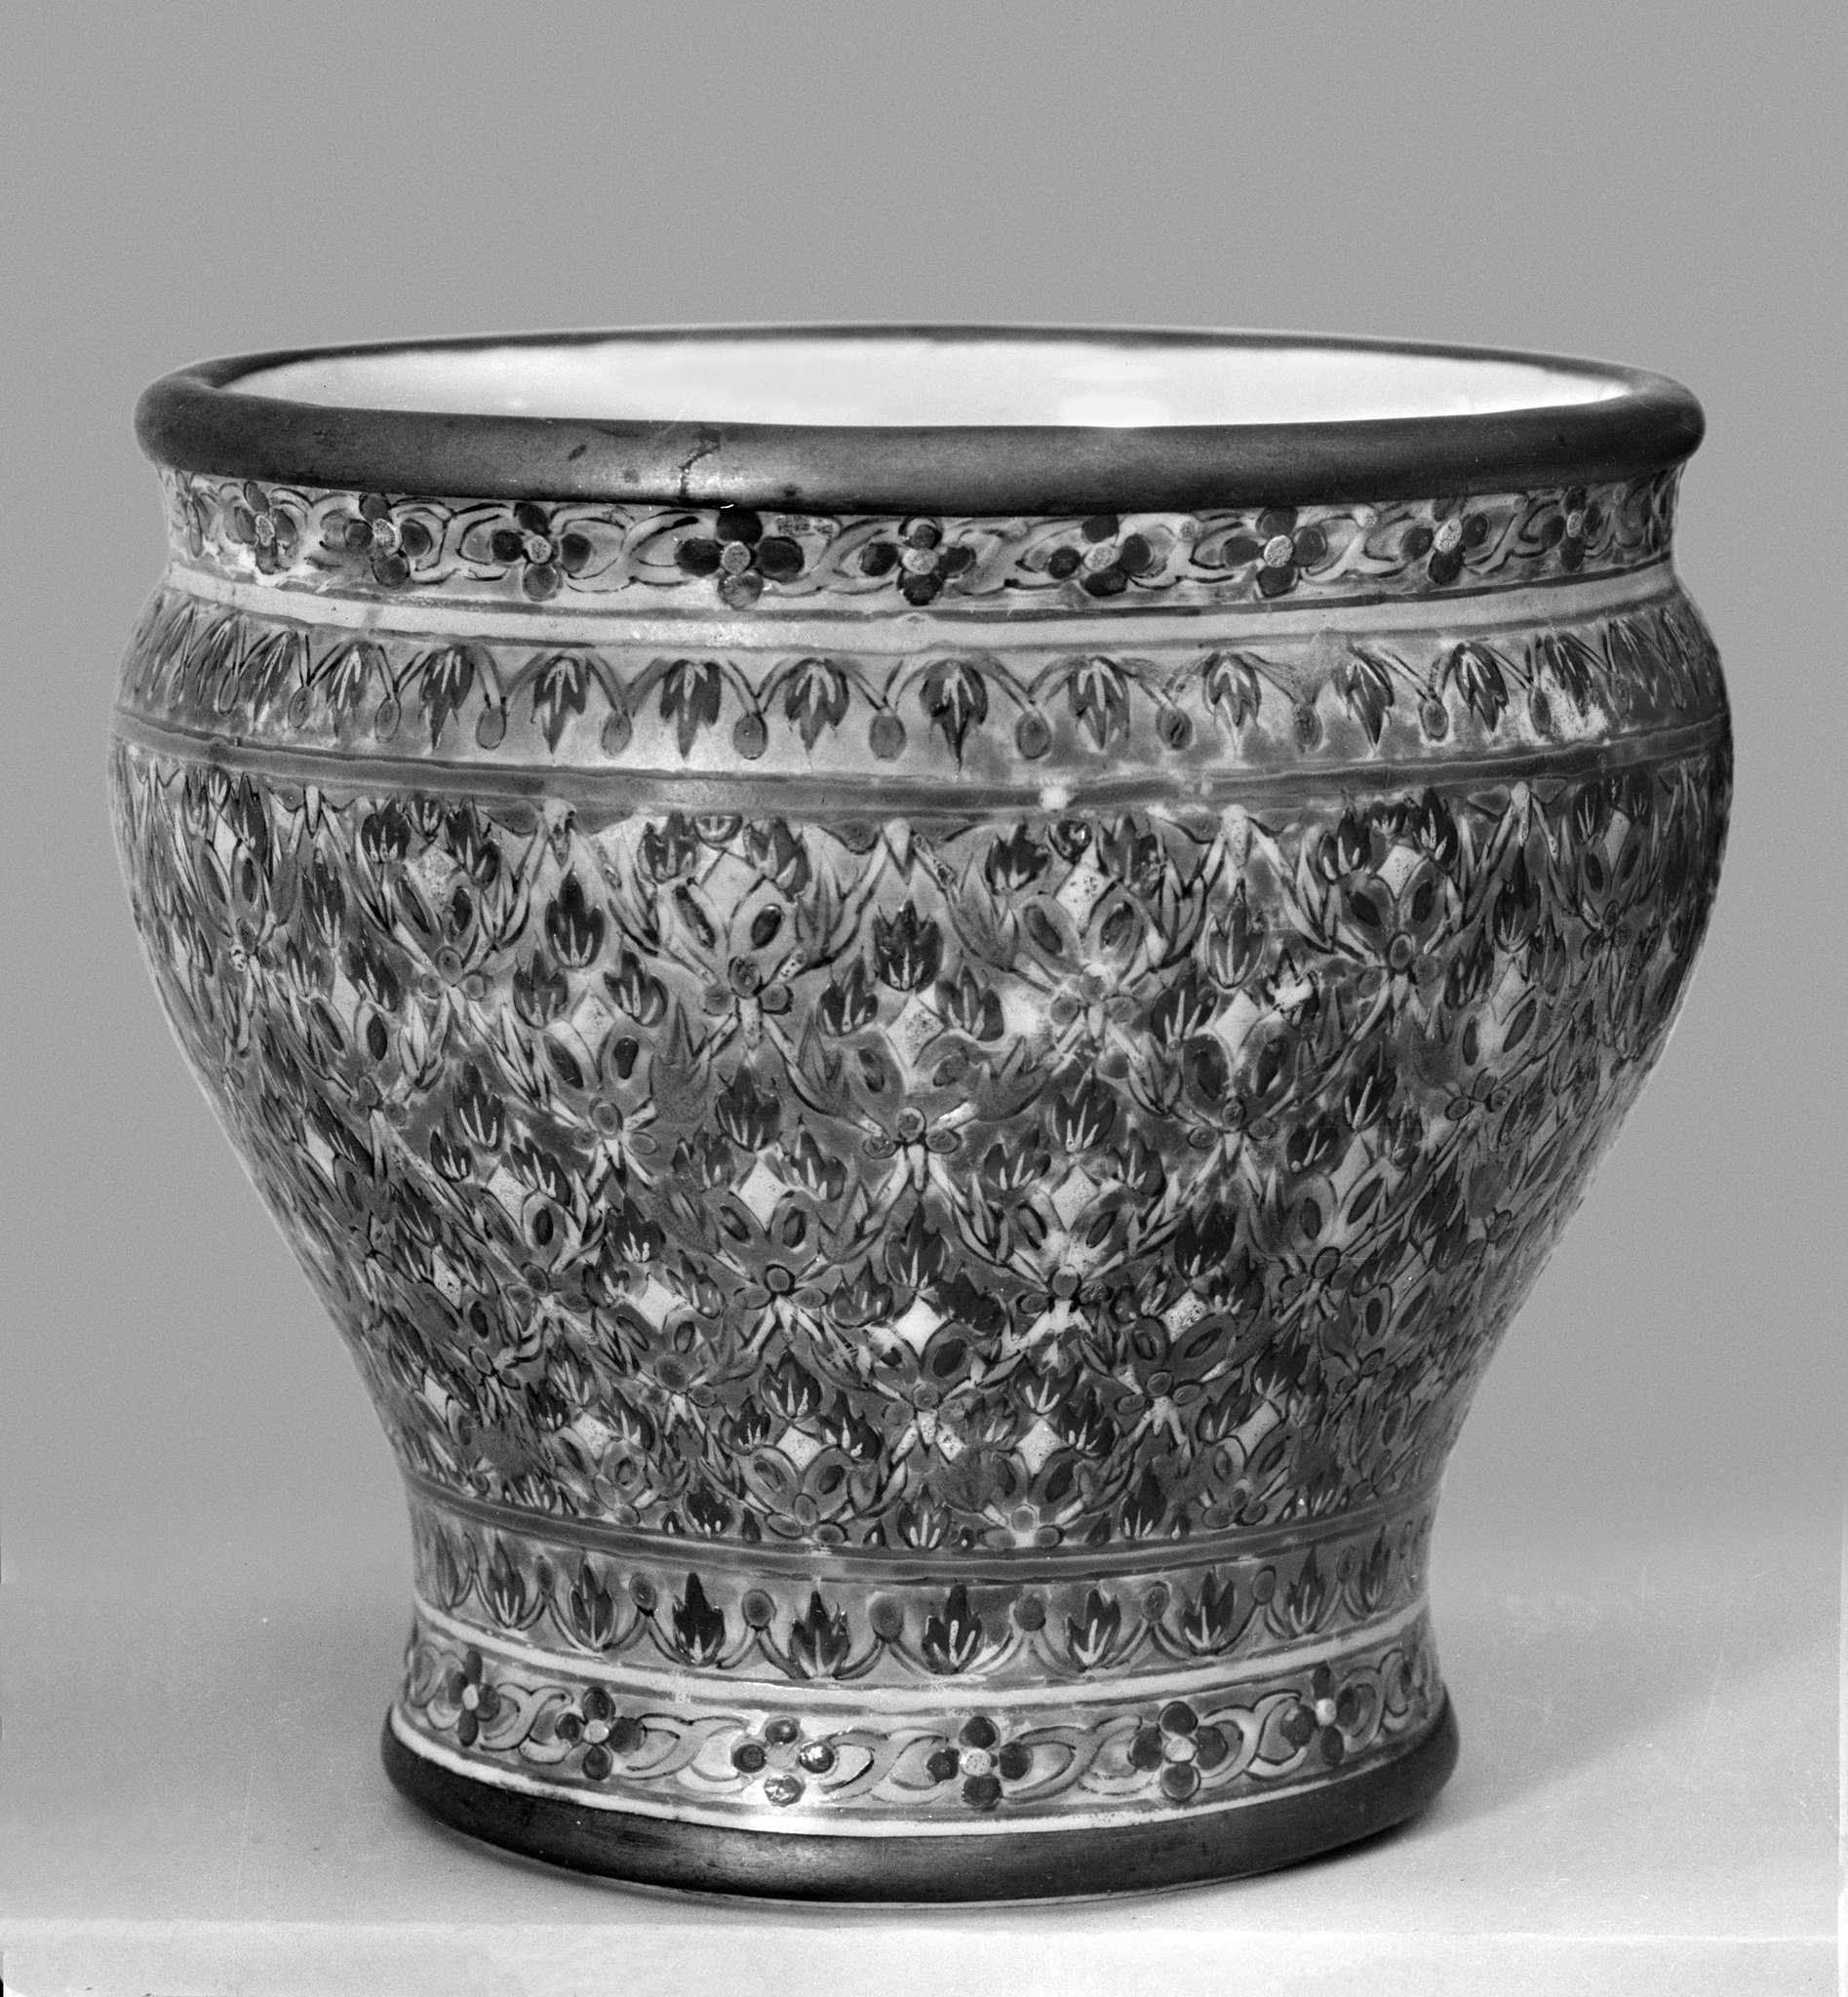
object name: jar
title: Jar with floral pattern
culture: chinese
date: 1801-1900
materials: enamel, porcelain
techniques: overglaze, painting, polychrome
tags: leaves